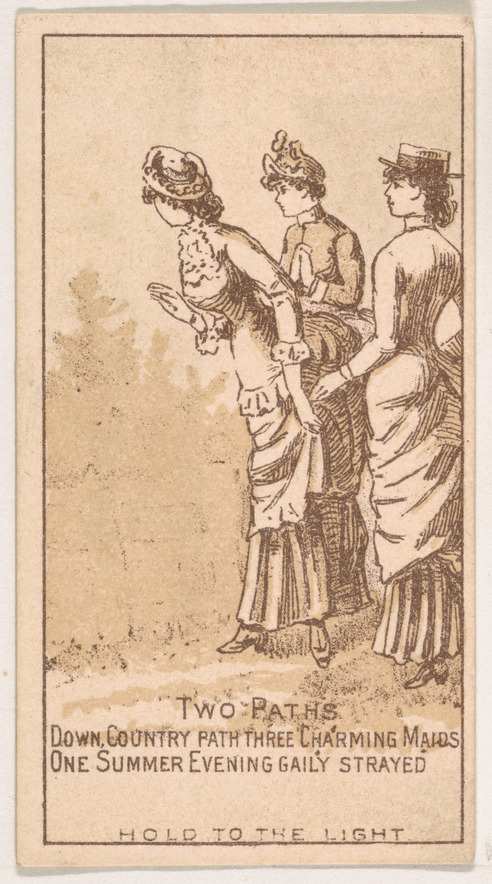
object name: print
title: Two Paths, from the Magic Changing Cards series (N223) issued by Kinney Tobacco Company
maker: kinney brothers tobacco company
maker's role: publisher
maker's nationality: american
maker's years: 1869-2011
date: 1889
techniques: color lithograph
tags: women